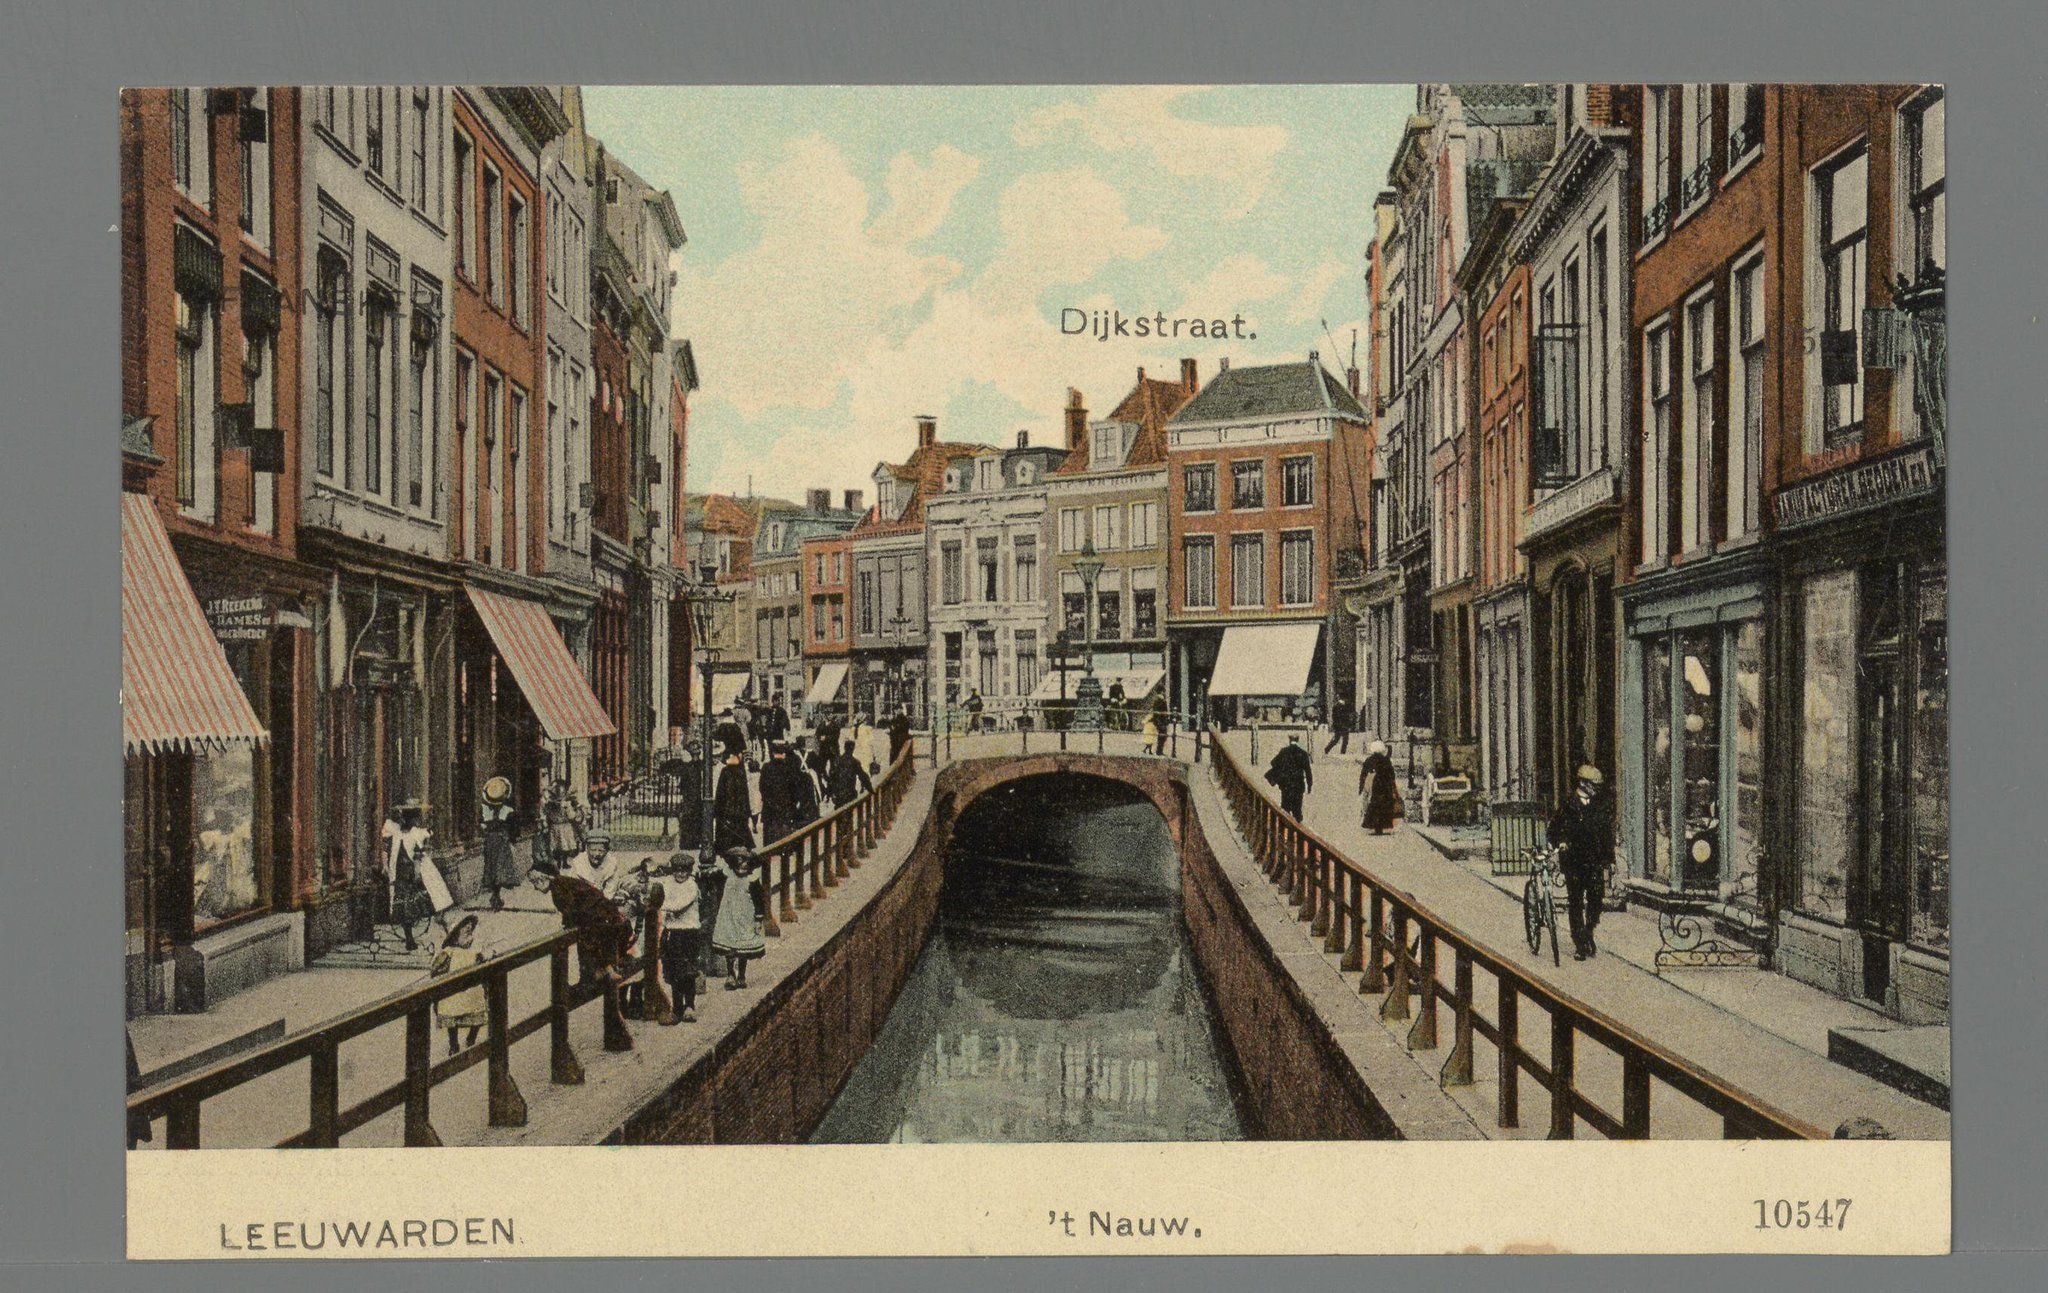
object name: ansichtkaart, prentbriefkaart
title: Dijkstraat. Leeuwarden. 't Nauw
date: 1905-1927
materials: cardboard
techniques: photograph, lithograph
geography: velsen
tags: canals, waters (in city), bridge in city across river, canal, etc., street